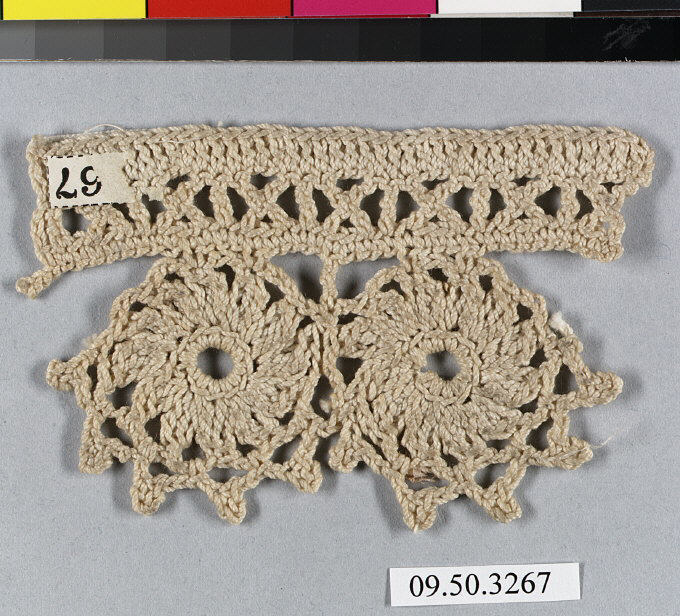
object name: sample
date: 1801-1900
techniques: crochet